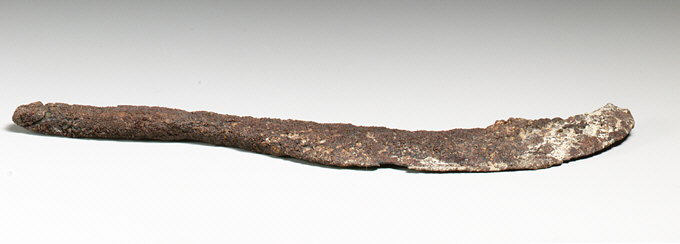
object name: knife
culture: cypriot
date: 3900 BCE-100 CE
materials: iron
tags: knives